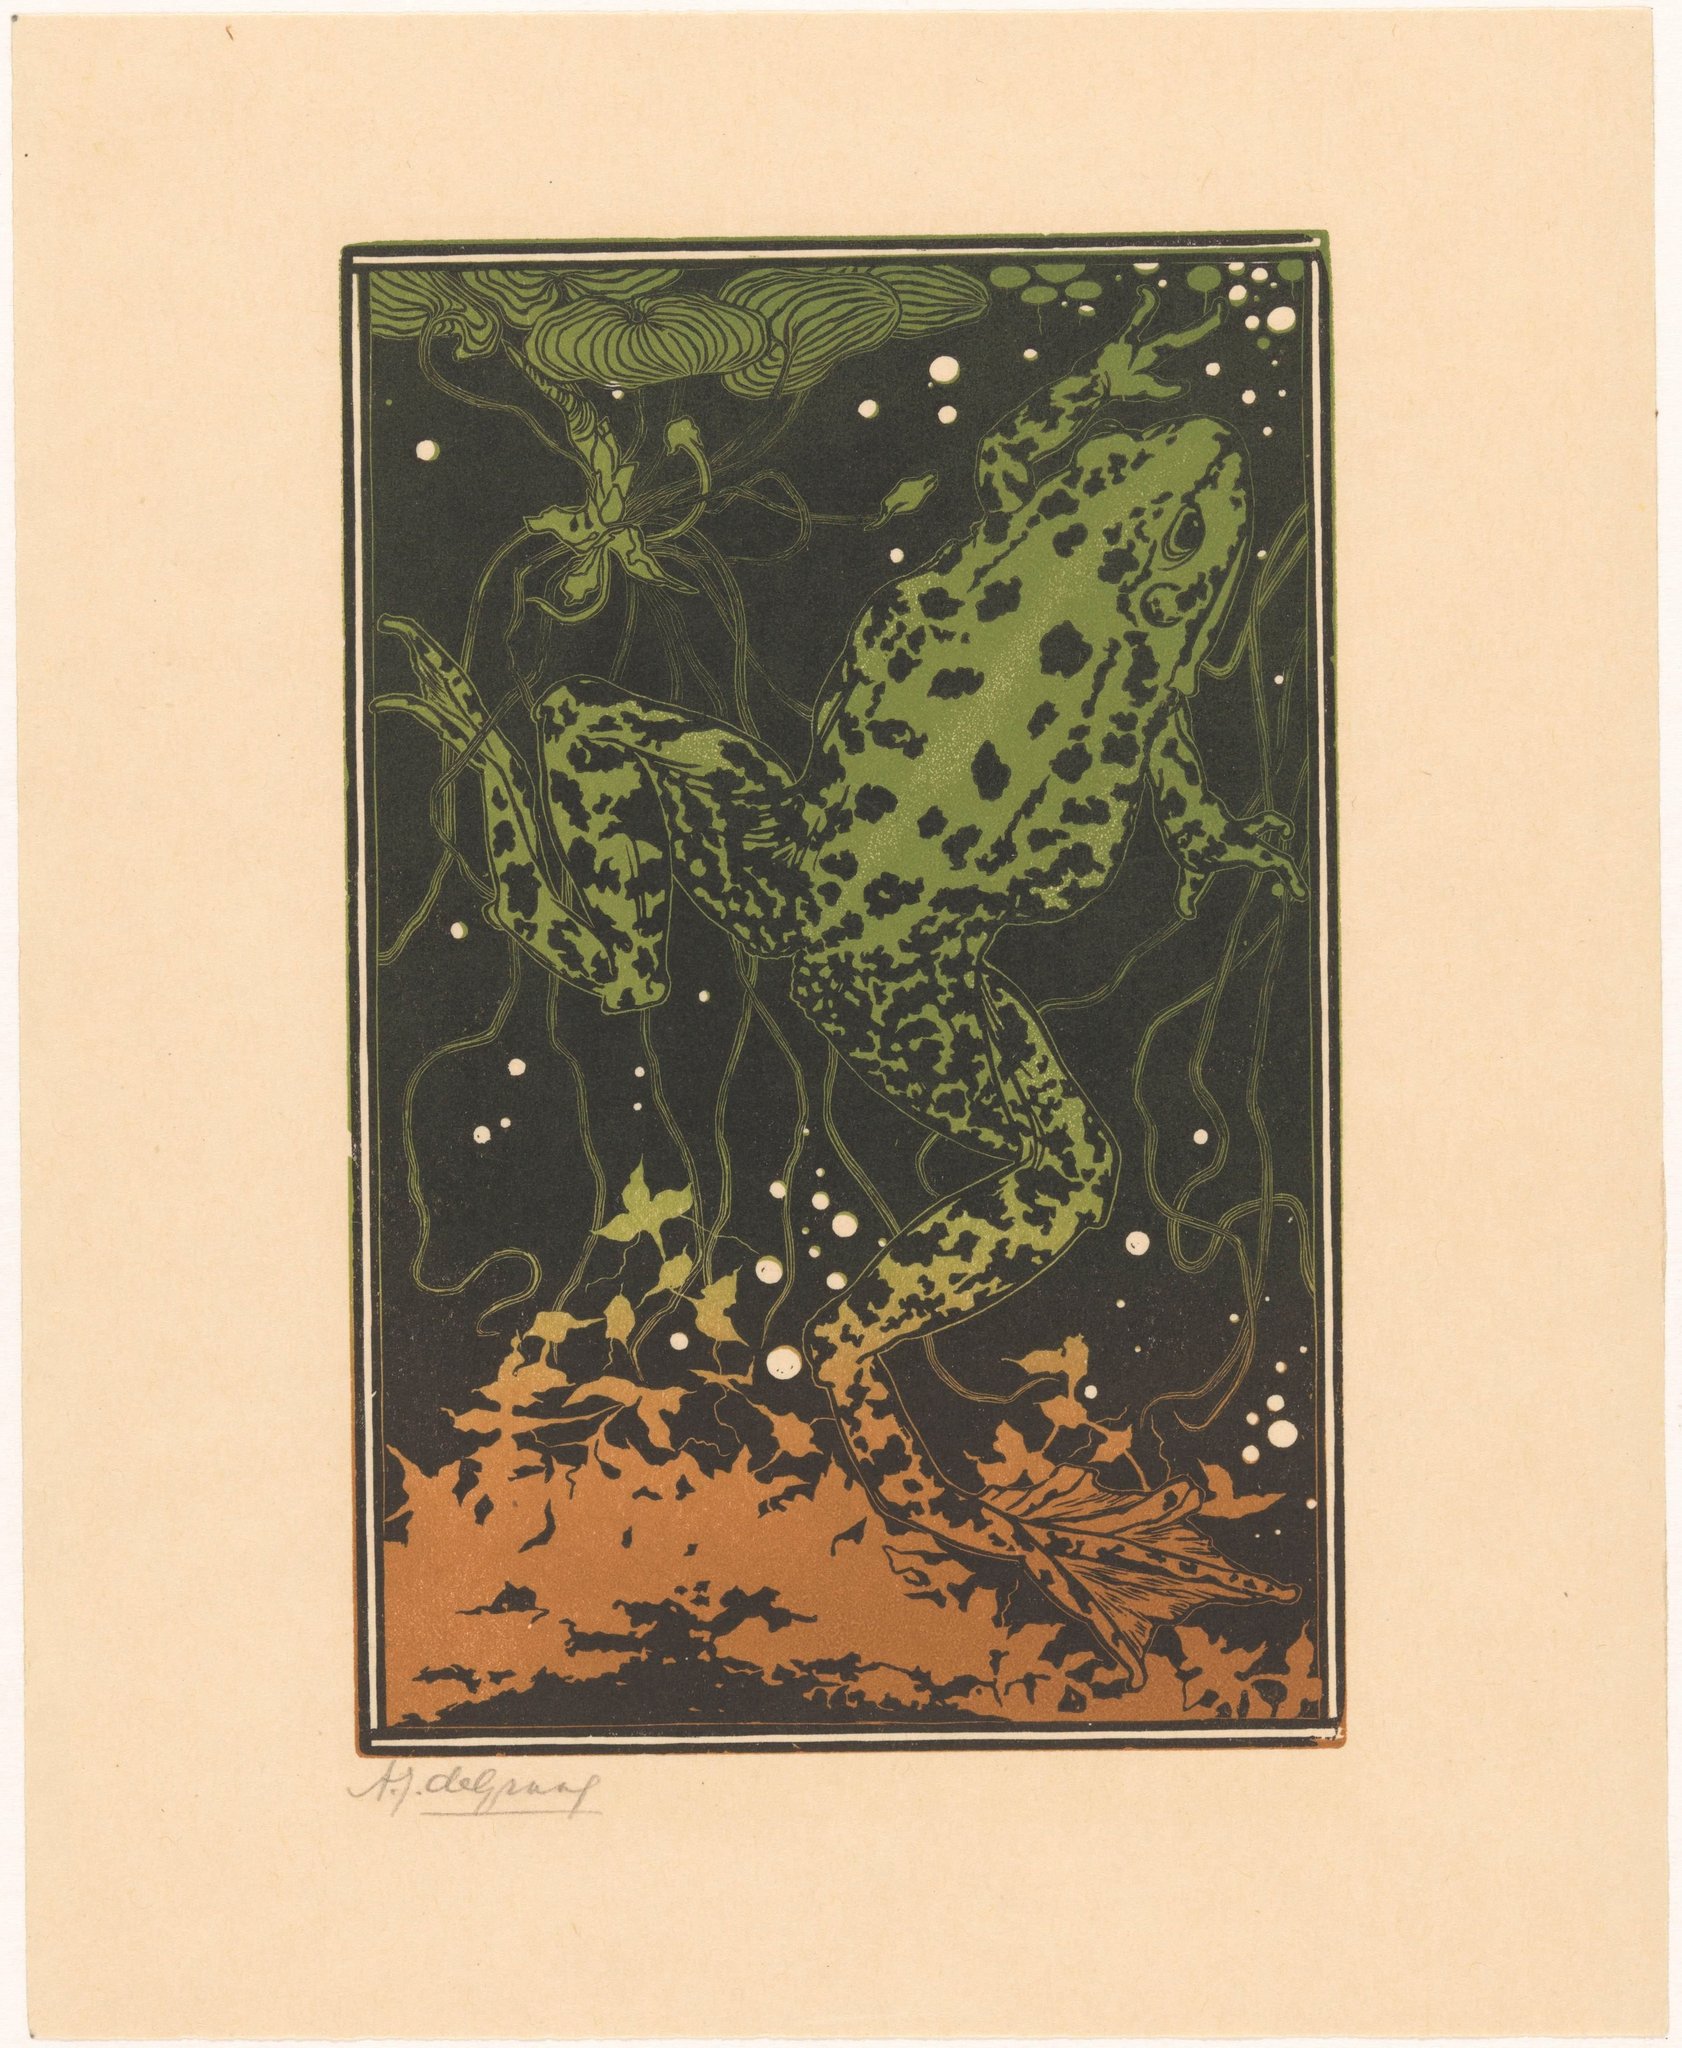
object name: print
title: Zwemmende kikker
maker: julie de graag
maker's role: draughtsman, print maker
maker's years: 1877-1924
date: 1887-1924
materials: paper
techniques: woodcut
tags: tailless amphibians: frog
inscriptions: collector's mark: Lugt 2228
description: Een zwemmende kikker te midden van luchtbellen en waterplanten.